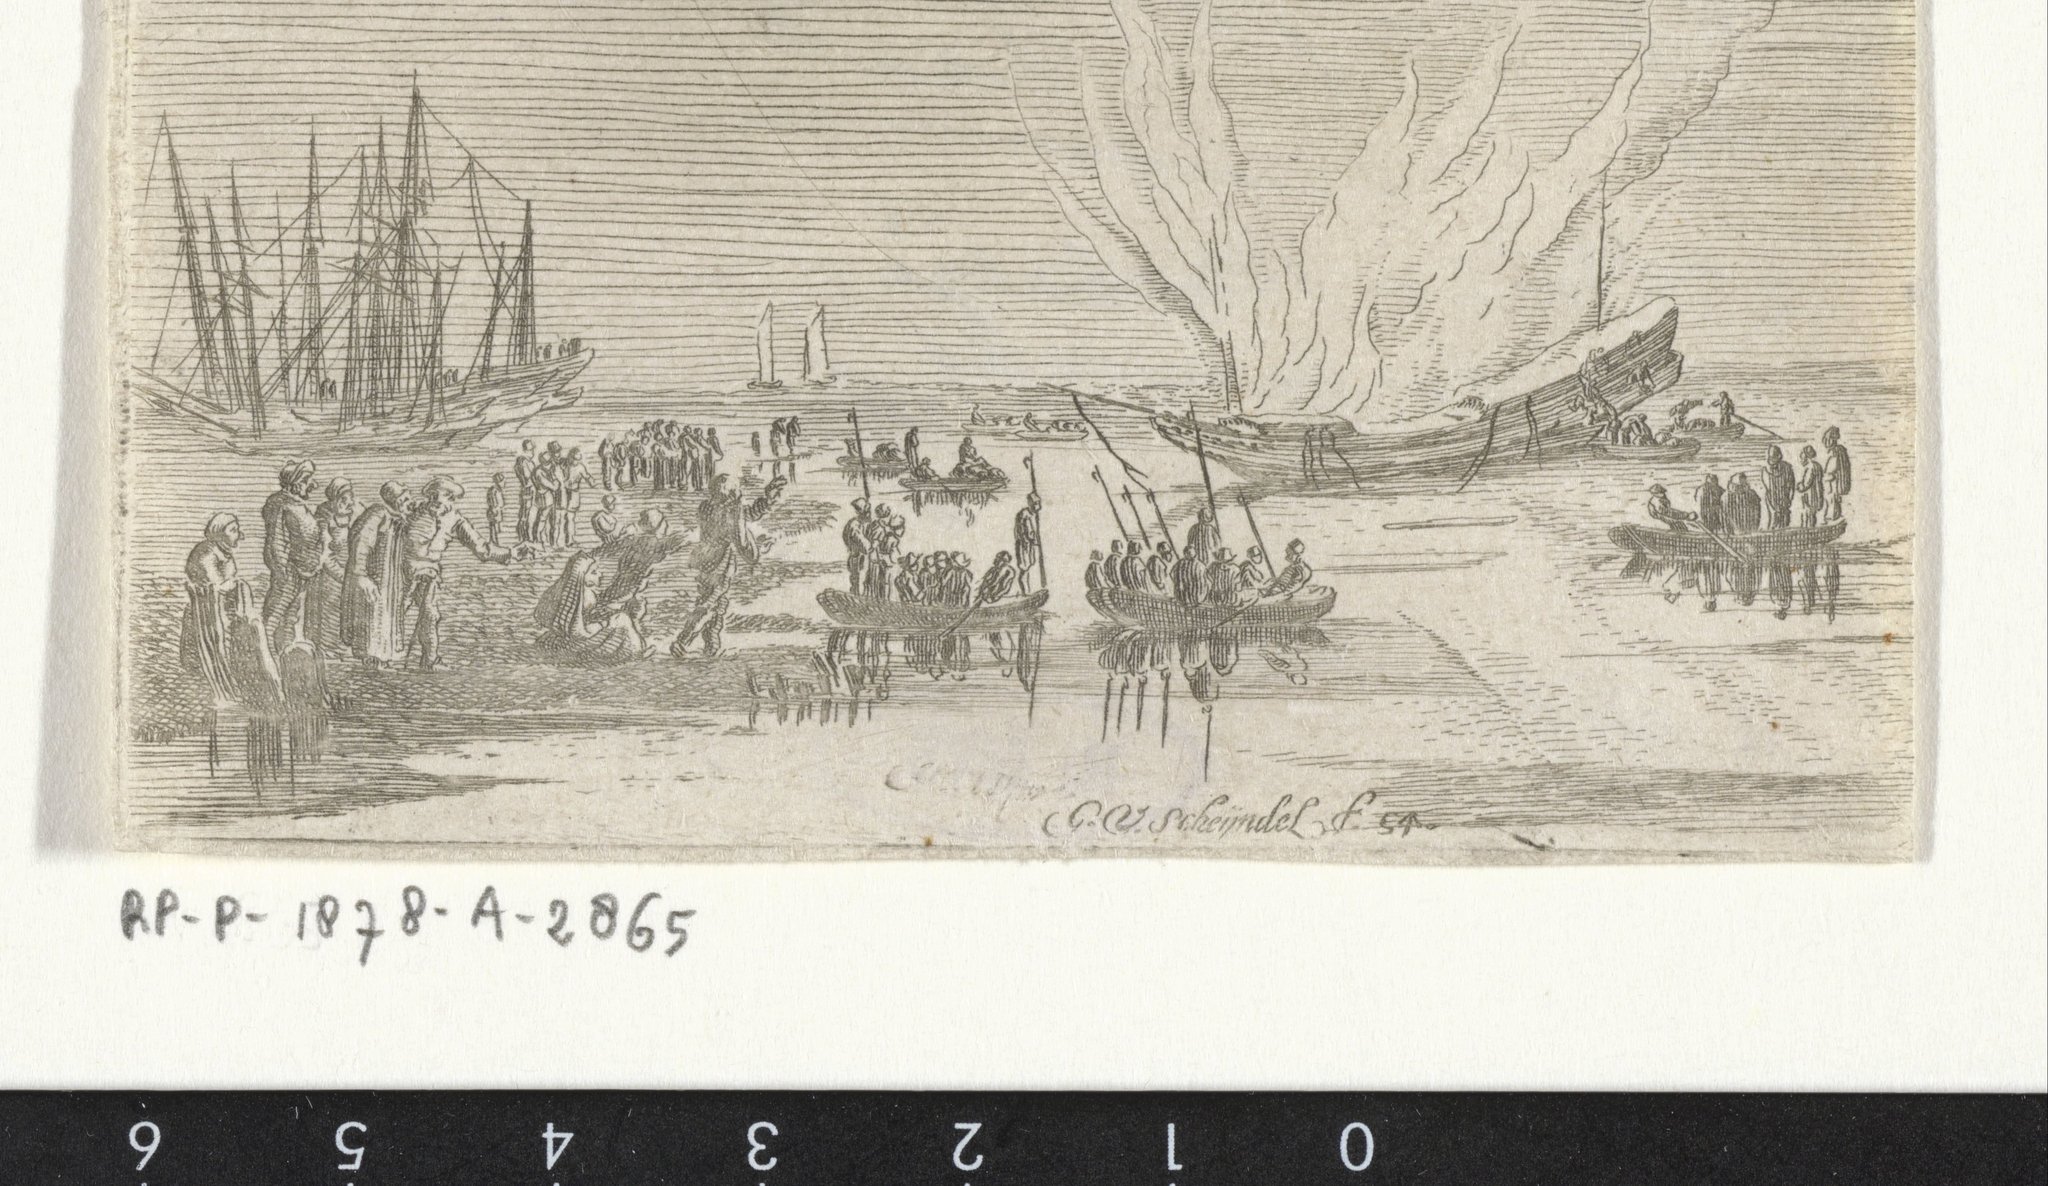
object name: print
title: Brandend schip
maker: gillis van scheyndel (i)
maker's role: draughtsman, print maker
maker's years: 1595-1660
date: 1605-1653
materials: paper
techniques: etching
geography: netherlands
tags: setting on fire (of conquered city) (+ sailing-ships)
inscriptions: collector's mark: Lugt 2228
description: Een brandend schip omgeven door verschillende schuitjes. Op een afstandje staan figuren te kijken.